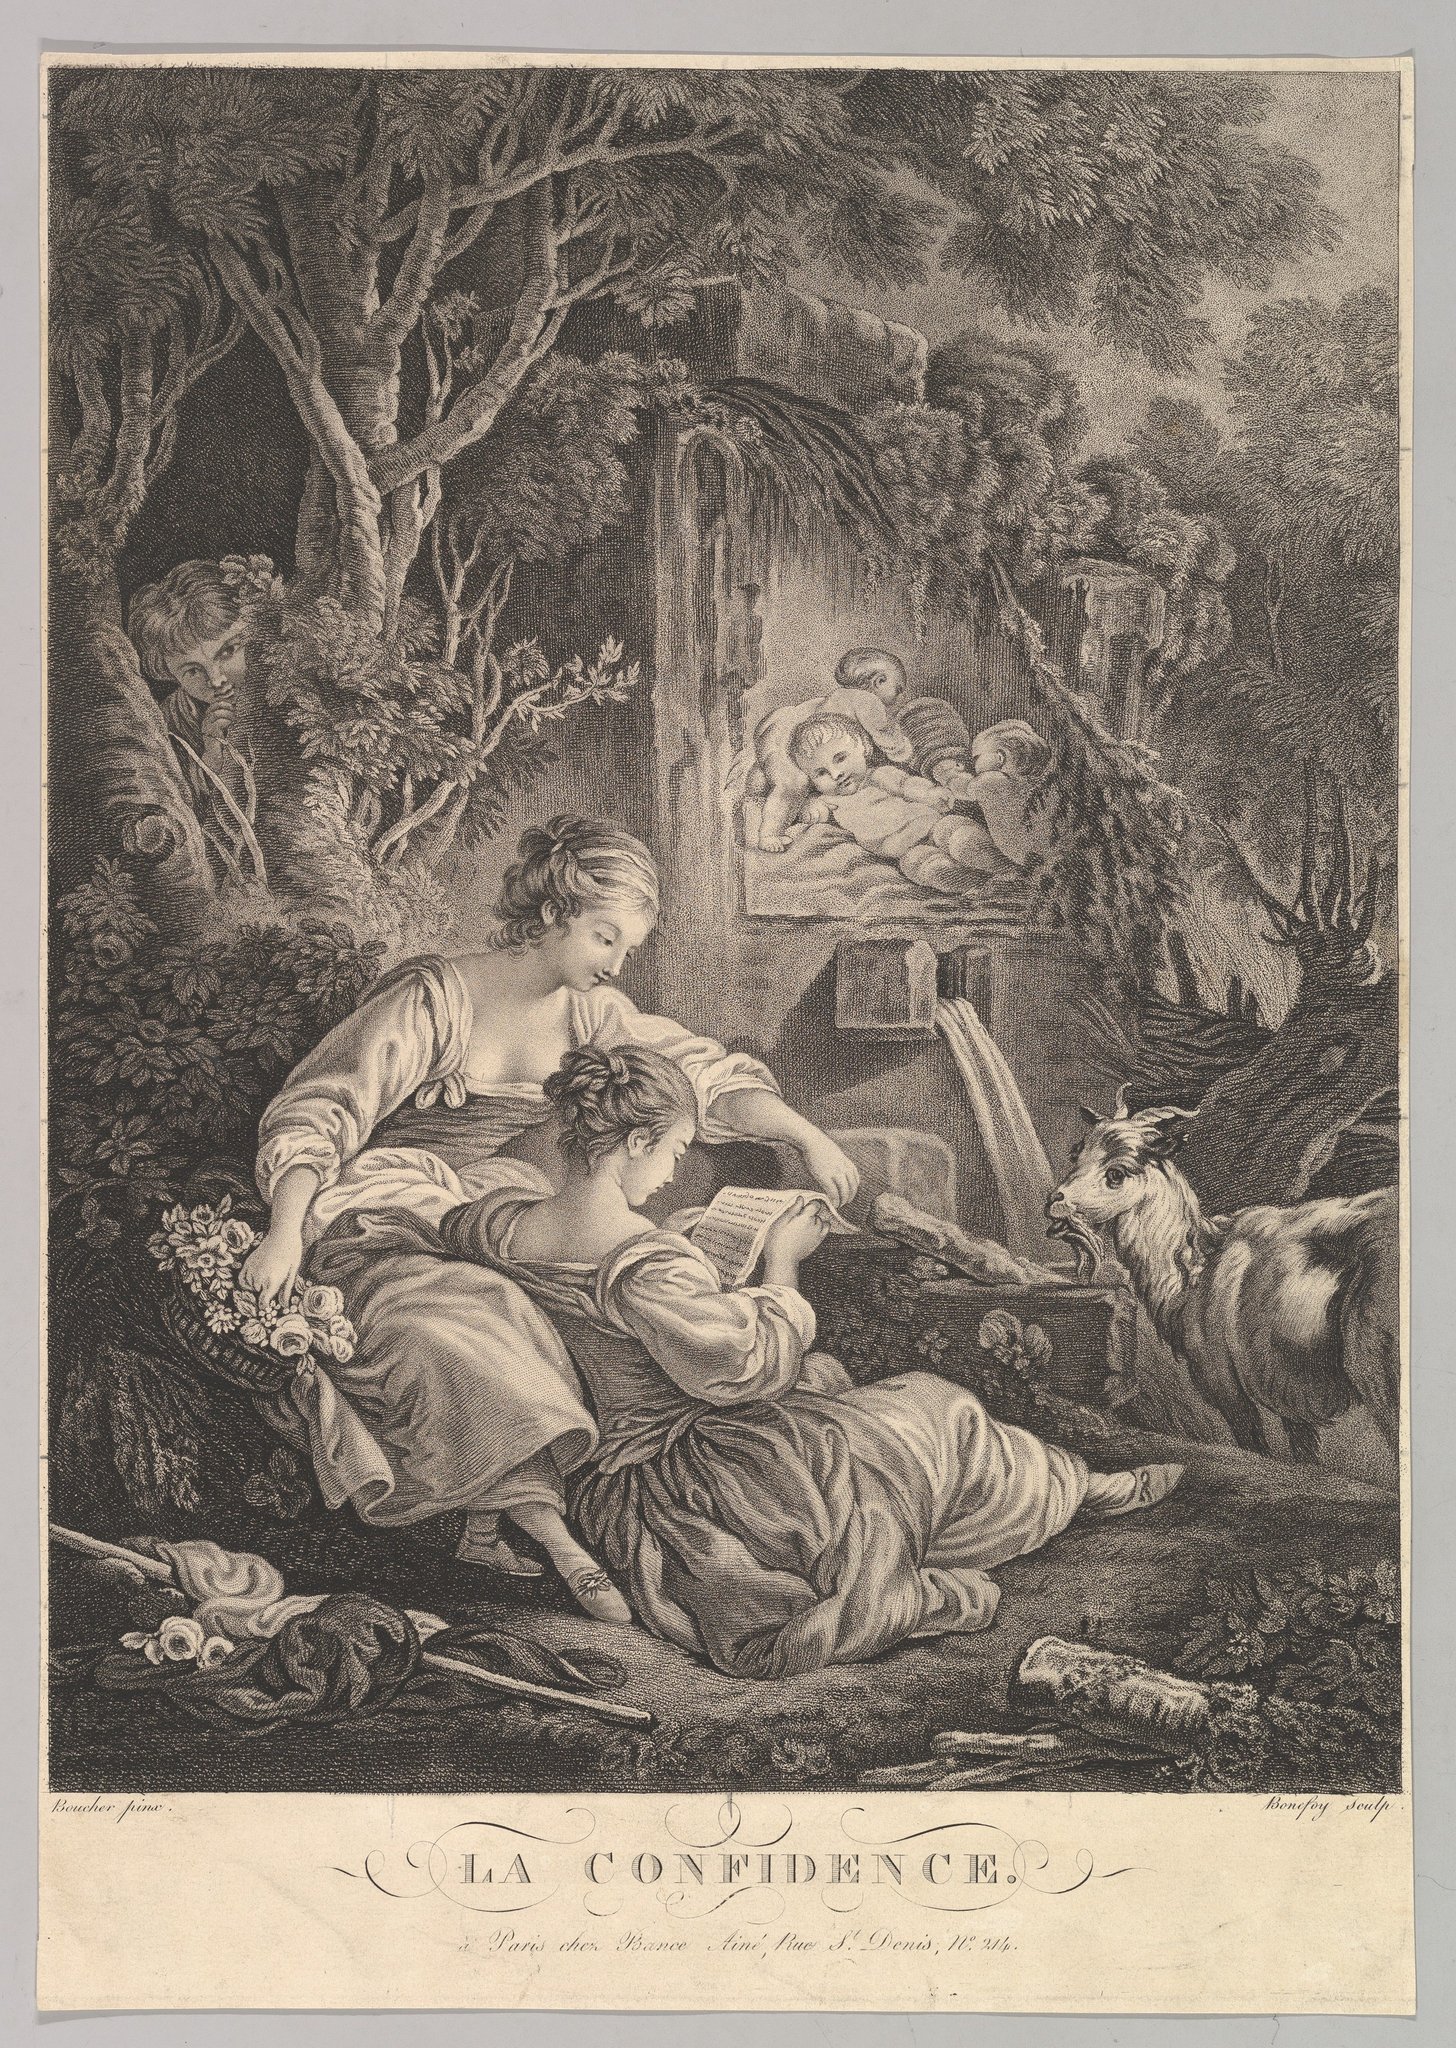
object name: print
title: The Secret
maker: jacques bonnefoy d'arles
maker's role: artist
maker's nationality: french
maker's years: 1755-1828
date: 1804-1831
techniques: engraving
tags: children,women,reading,goats